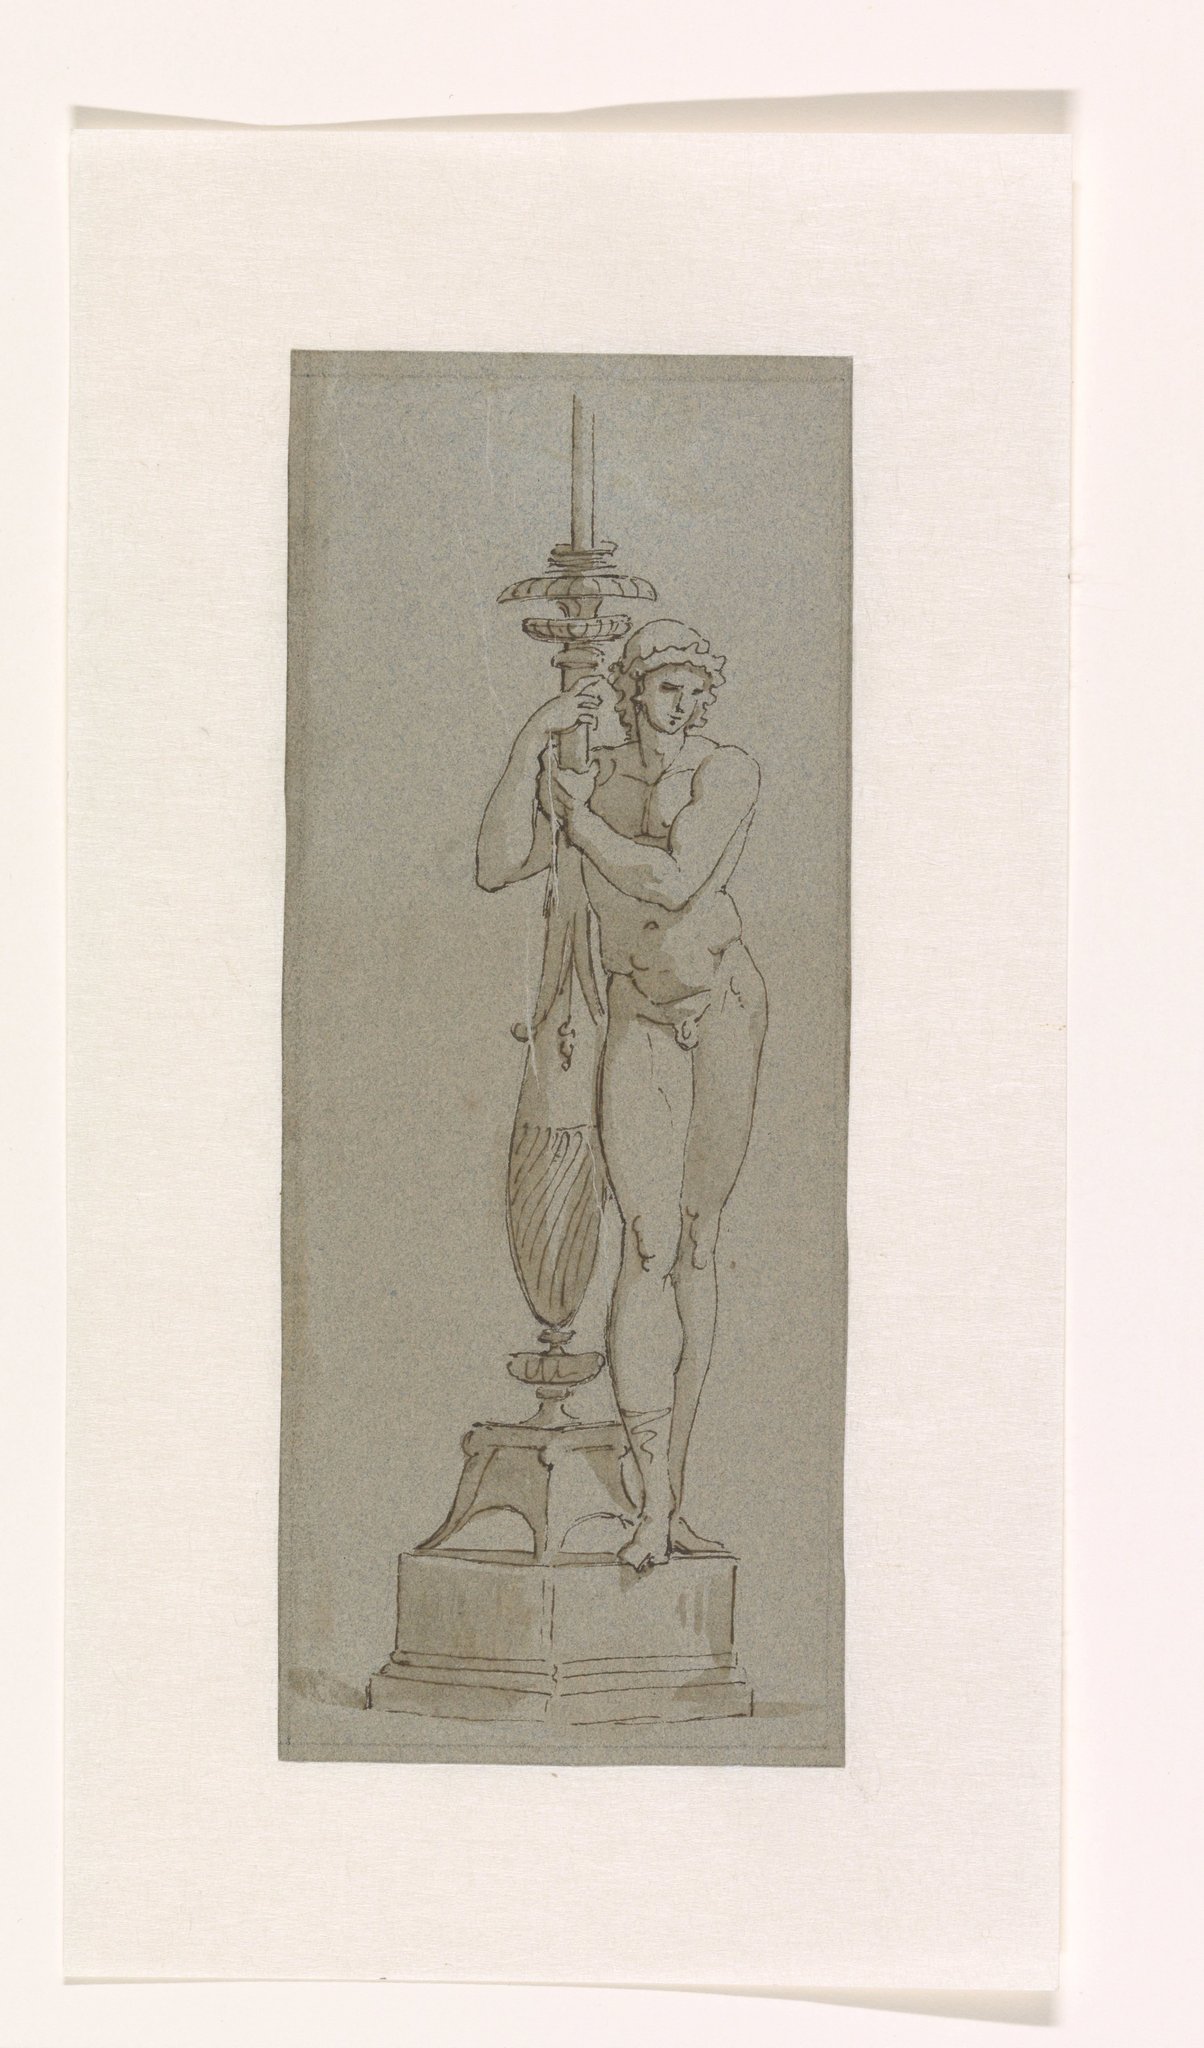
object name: design drawing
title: Two designs for candlesticks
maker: giuseppe cades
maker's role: print maker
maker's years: 1750-1799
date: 1795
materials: ink, paper, pencil, watercolor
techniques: brush, pen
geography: rome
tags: standing figure, candlestick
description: The artist, probably a sculptor, represents candlesticks whose main component is formed of a human figure. They were probably intended to be executed in bronze. The style is strongly influenced by Italian models; it is conceivable that the drawings are in fact Italian.